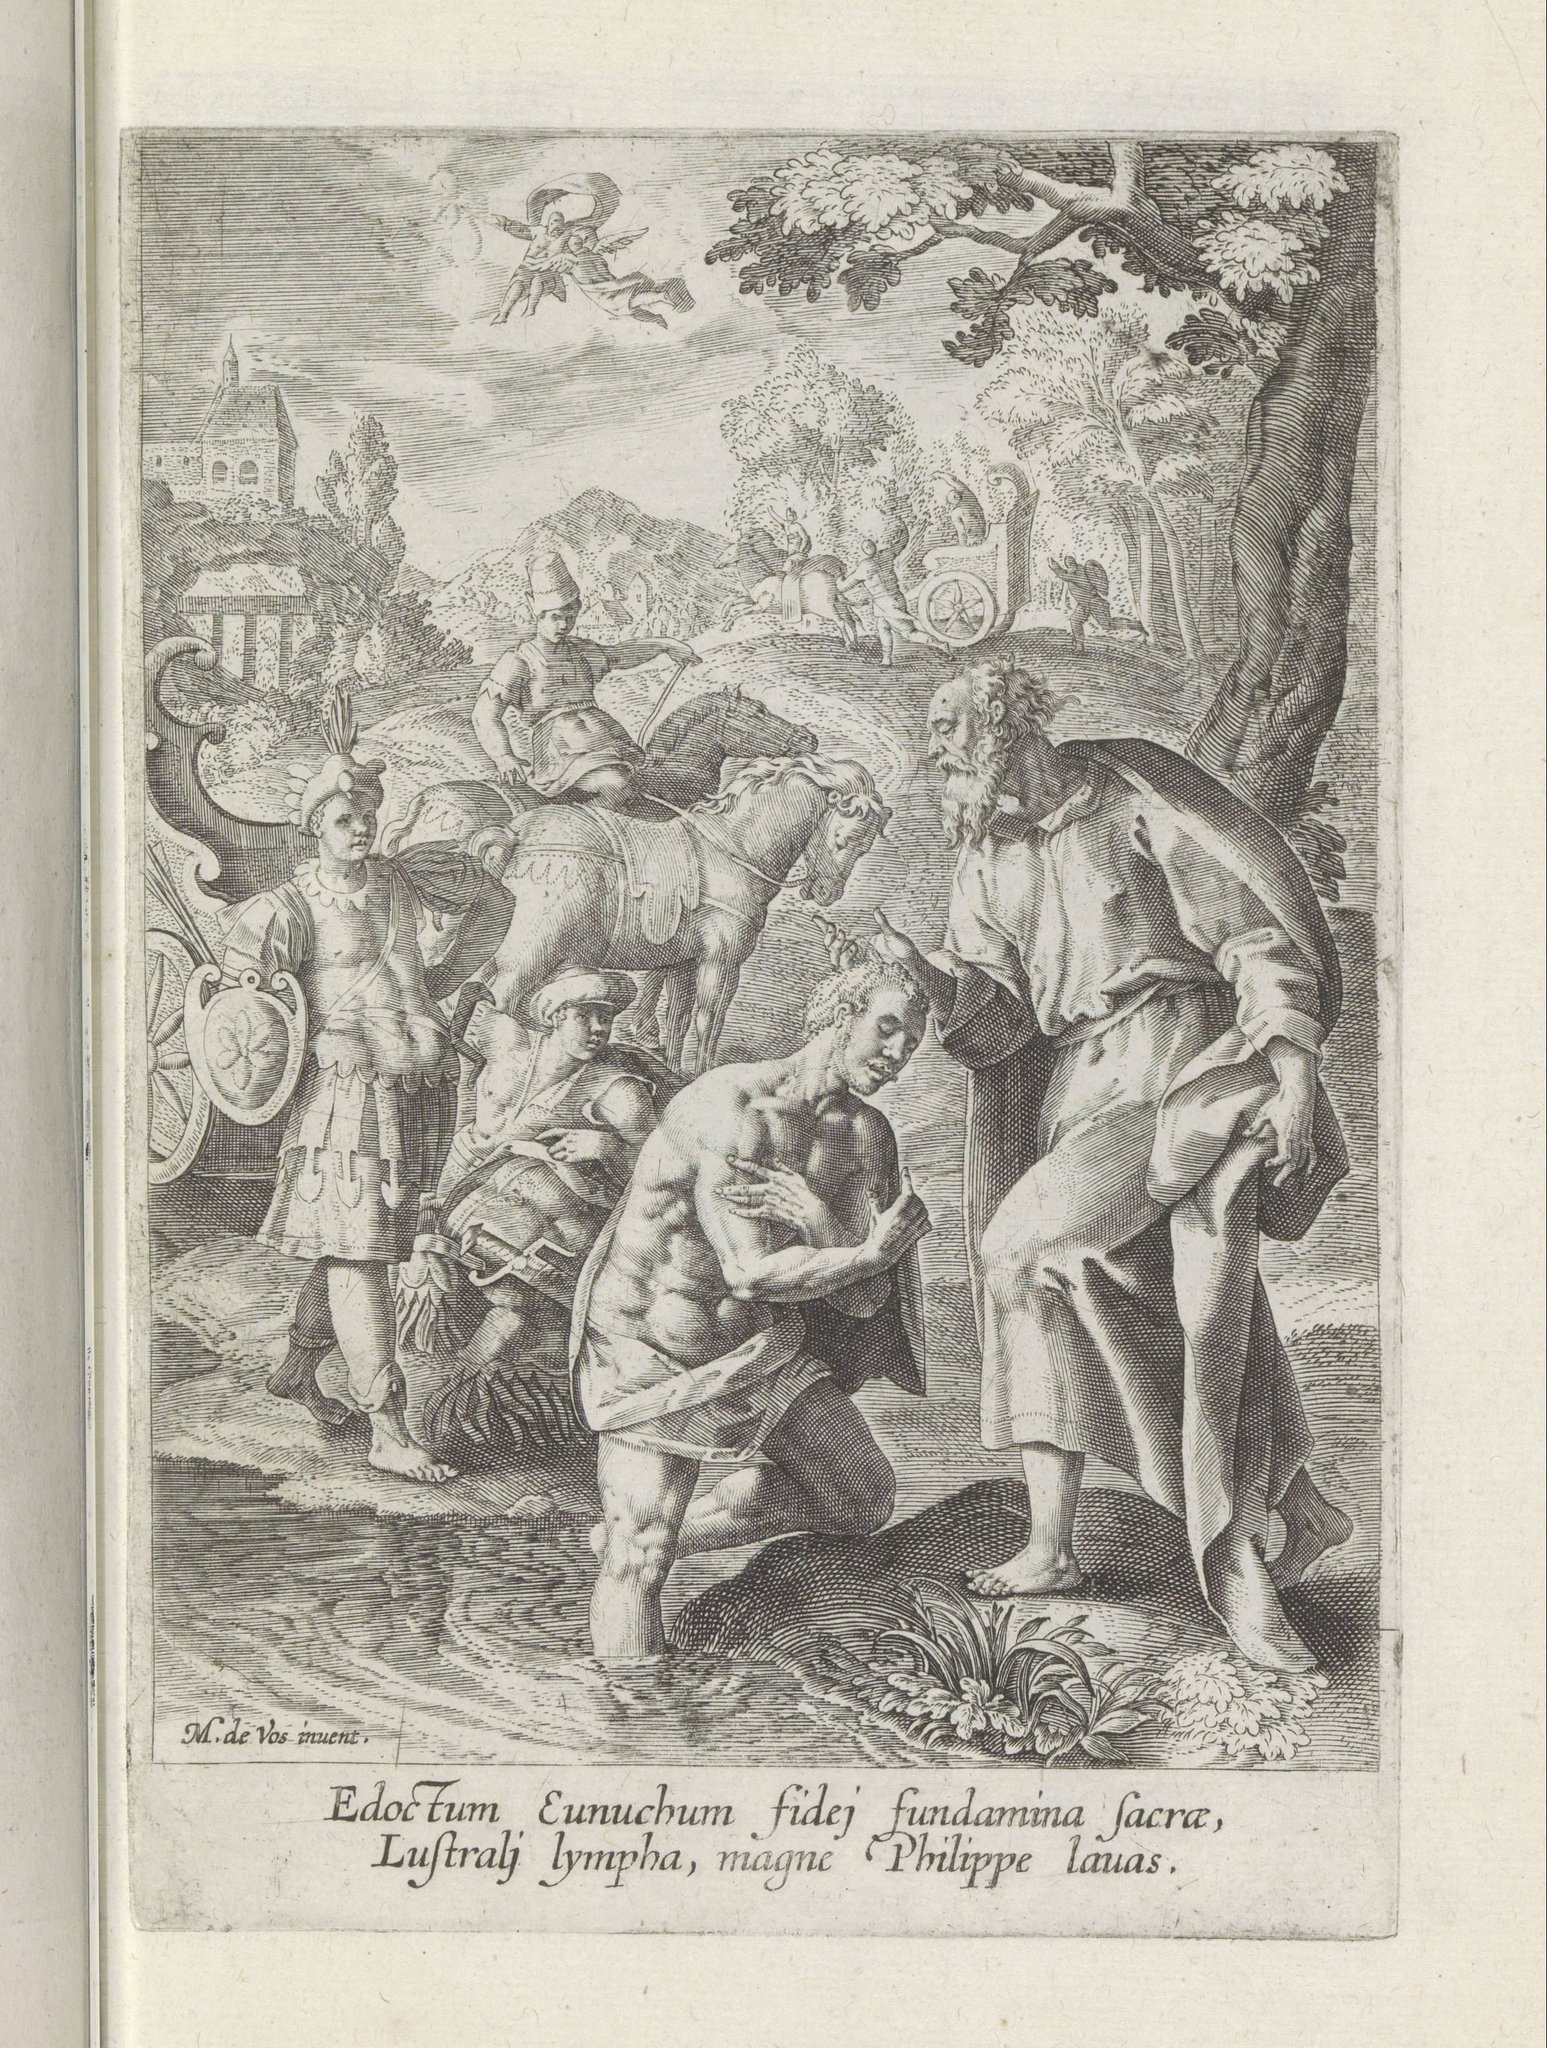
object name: print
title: Doop van de kamerling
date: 1585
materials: paper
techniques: engraving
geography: antwerp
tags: philip baptizes the eunuch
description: Deze serie draagt op een van de prenten het signatuur van de weduwe van uitgever Gerard de Jode. De eerste datering is gebaseerd op de datum van uitgave van het album. De tweede datering is gebaseerd op het sterfjaar van Gerard de Jode (1591) en het jaar waarin zijn zoon overleed (1600) en de platen werden verkocht. Het is mogelijk dat deze serie later aan het album is toegevoegd. Waarschijnlijker is het dat het gehele album tussen 1591 en 1600 is gebonden, omdat deze serie is meegebonden in het album.